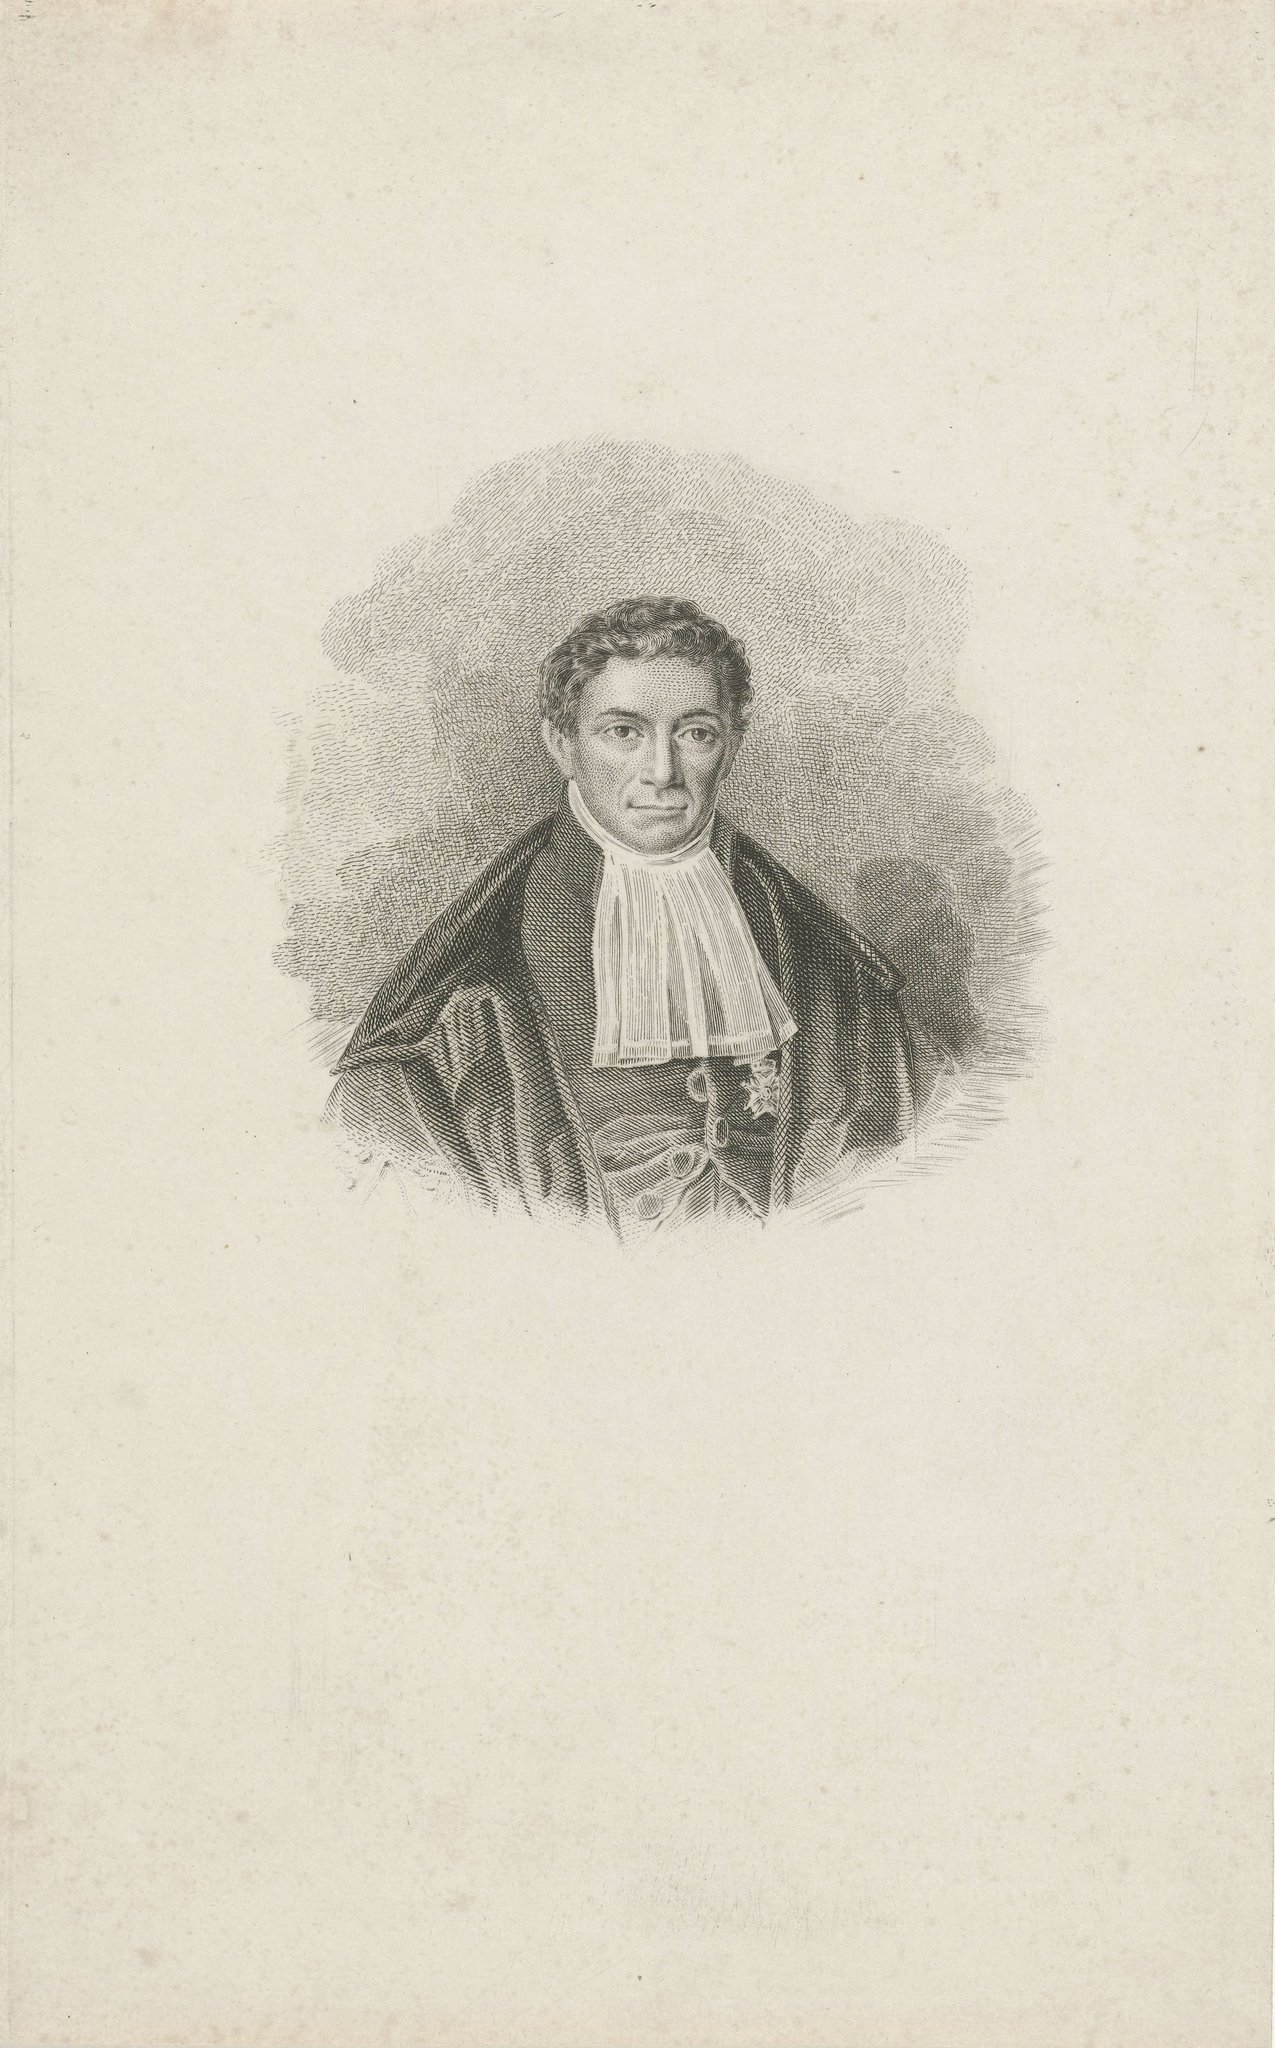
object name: print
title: Portret van Sibrandus Stratingh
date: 1841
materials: paper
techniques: engraving, etching, roulette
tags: adorp, groningen, hoogleraar, chemicus, sibrandus stratingh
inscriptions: collector's mark: Lugt 2228